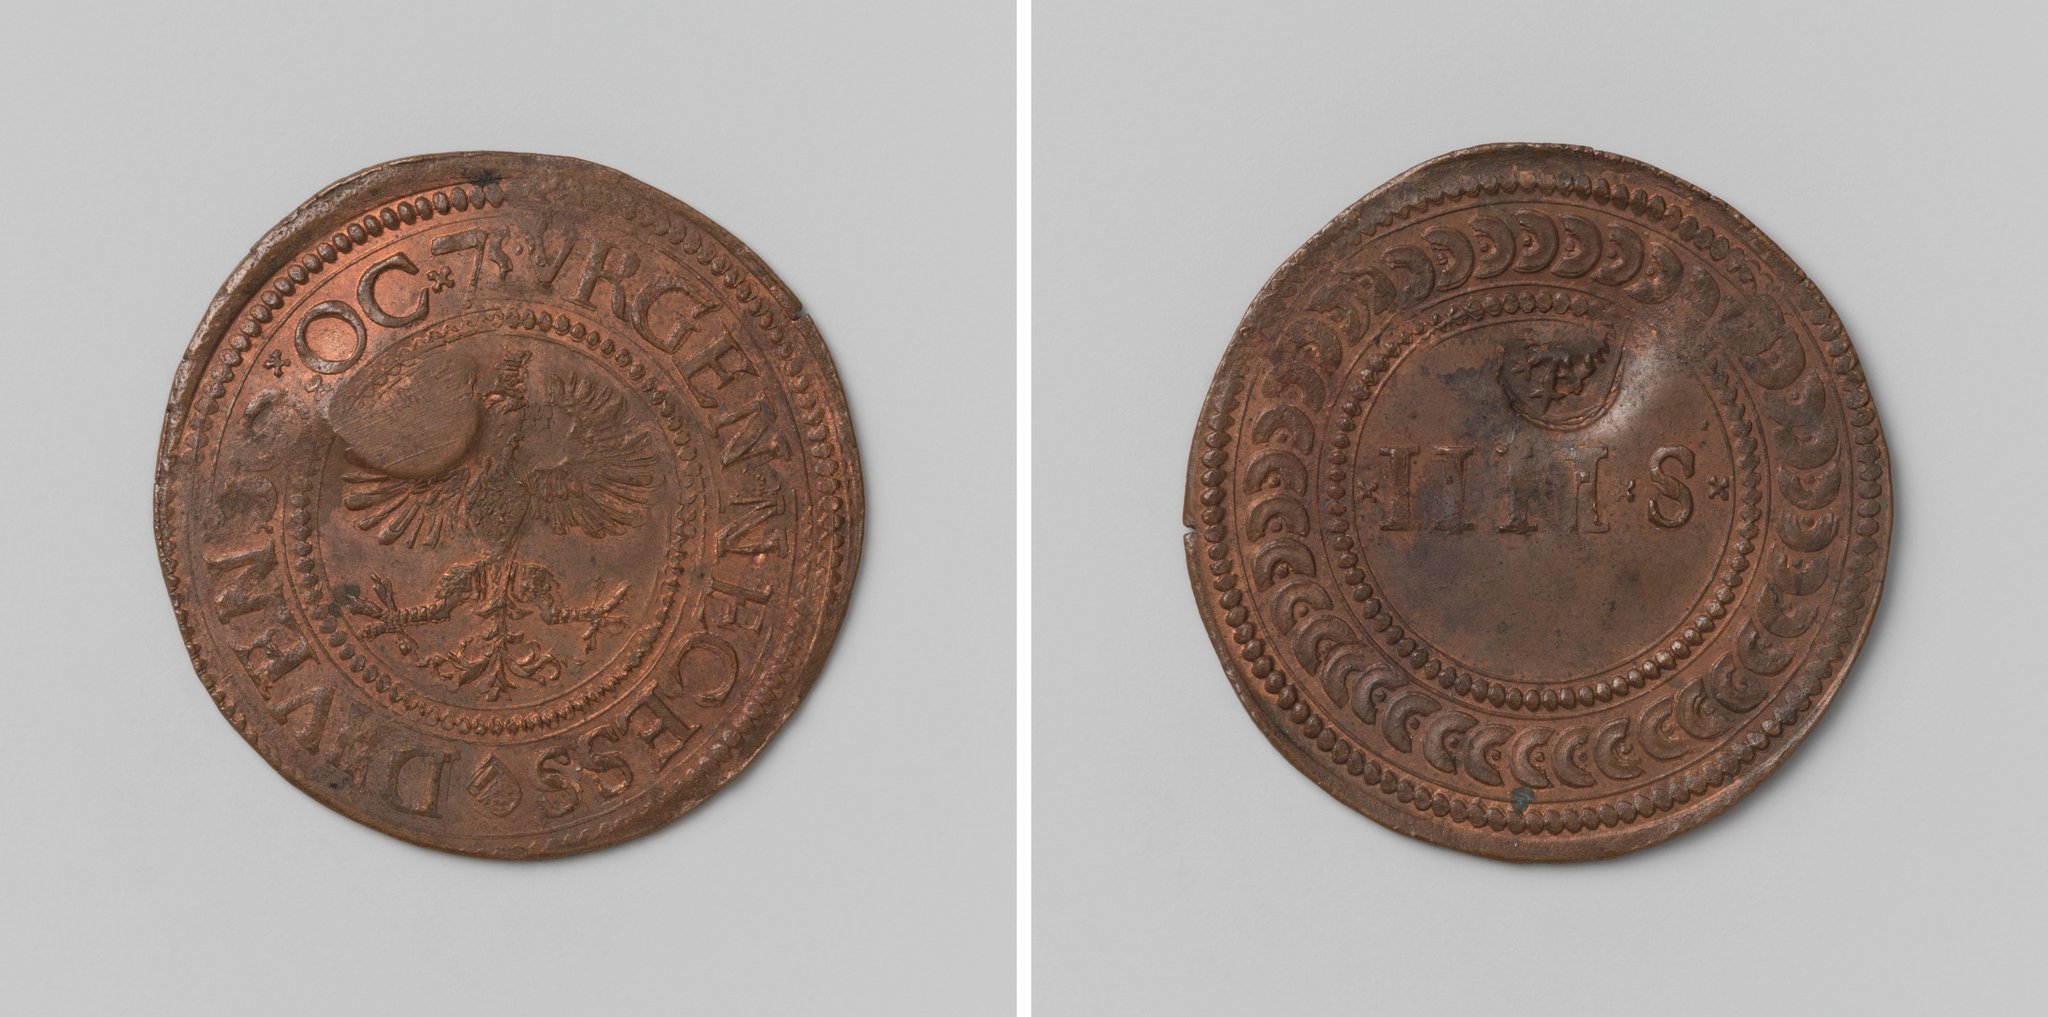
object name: vier stuiver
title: Vier stuiver, noodmunt uit Deventer, geslagen tijdens het beleg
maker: balthasar wijntgens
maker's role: mintmaster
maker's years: 1577-1592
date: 1578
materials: copper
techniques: striking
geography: deventer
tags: deventer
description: Voorzijde: gekroonde adelaar binnen omschrift. Keerzijde: Romeinse cijfer IIII en letter S binnen krans; klop: stadswapen